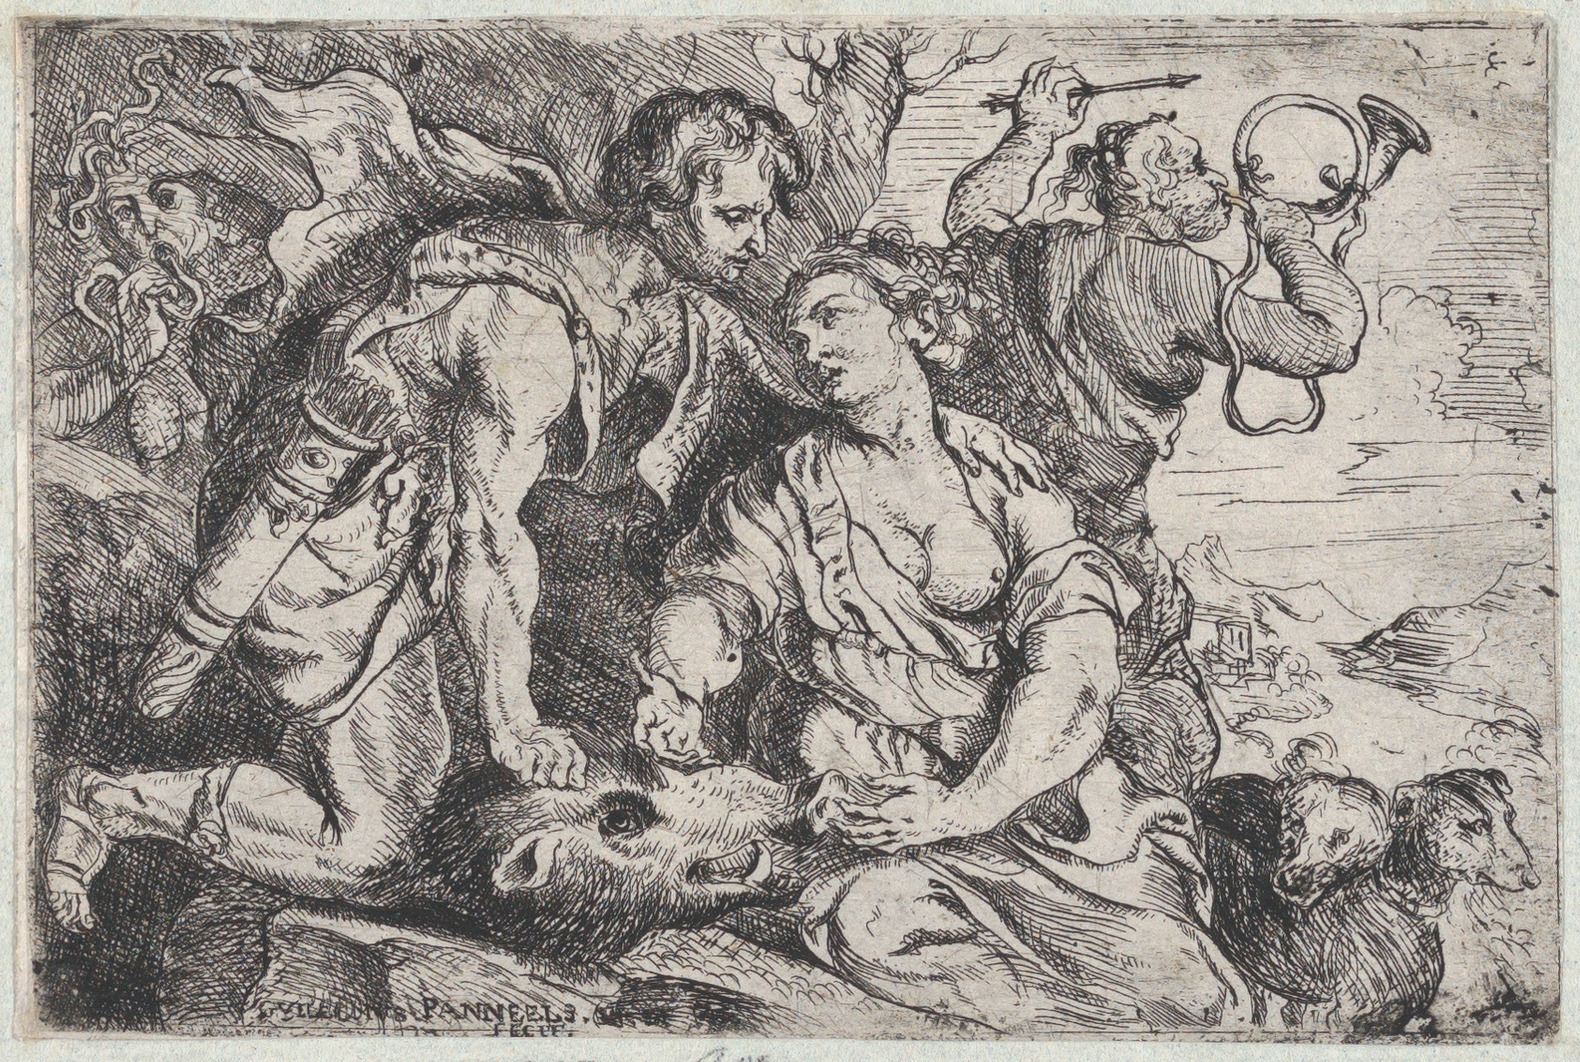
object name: print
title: Atalanta and Meleager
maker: willem panneels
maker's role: artist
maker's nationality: flemish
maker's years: 1600-1632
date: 1631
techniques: etching